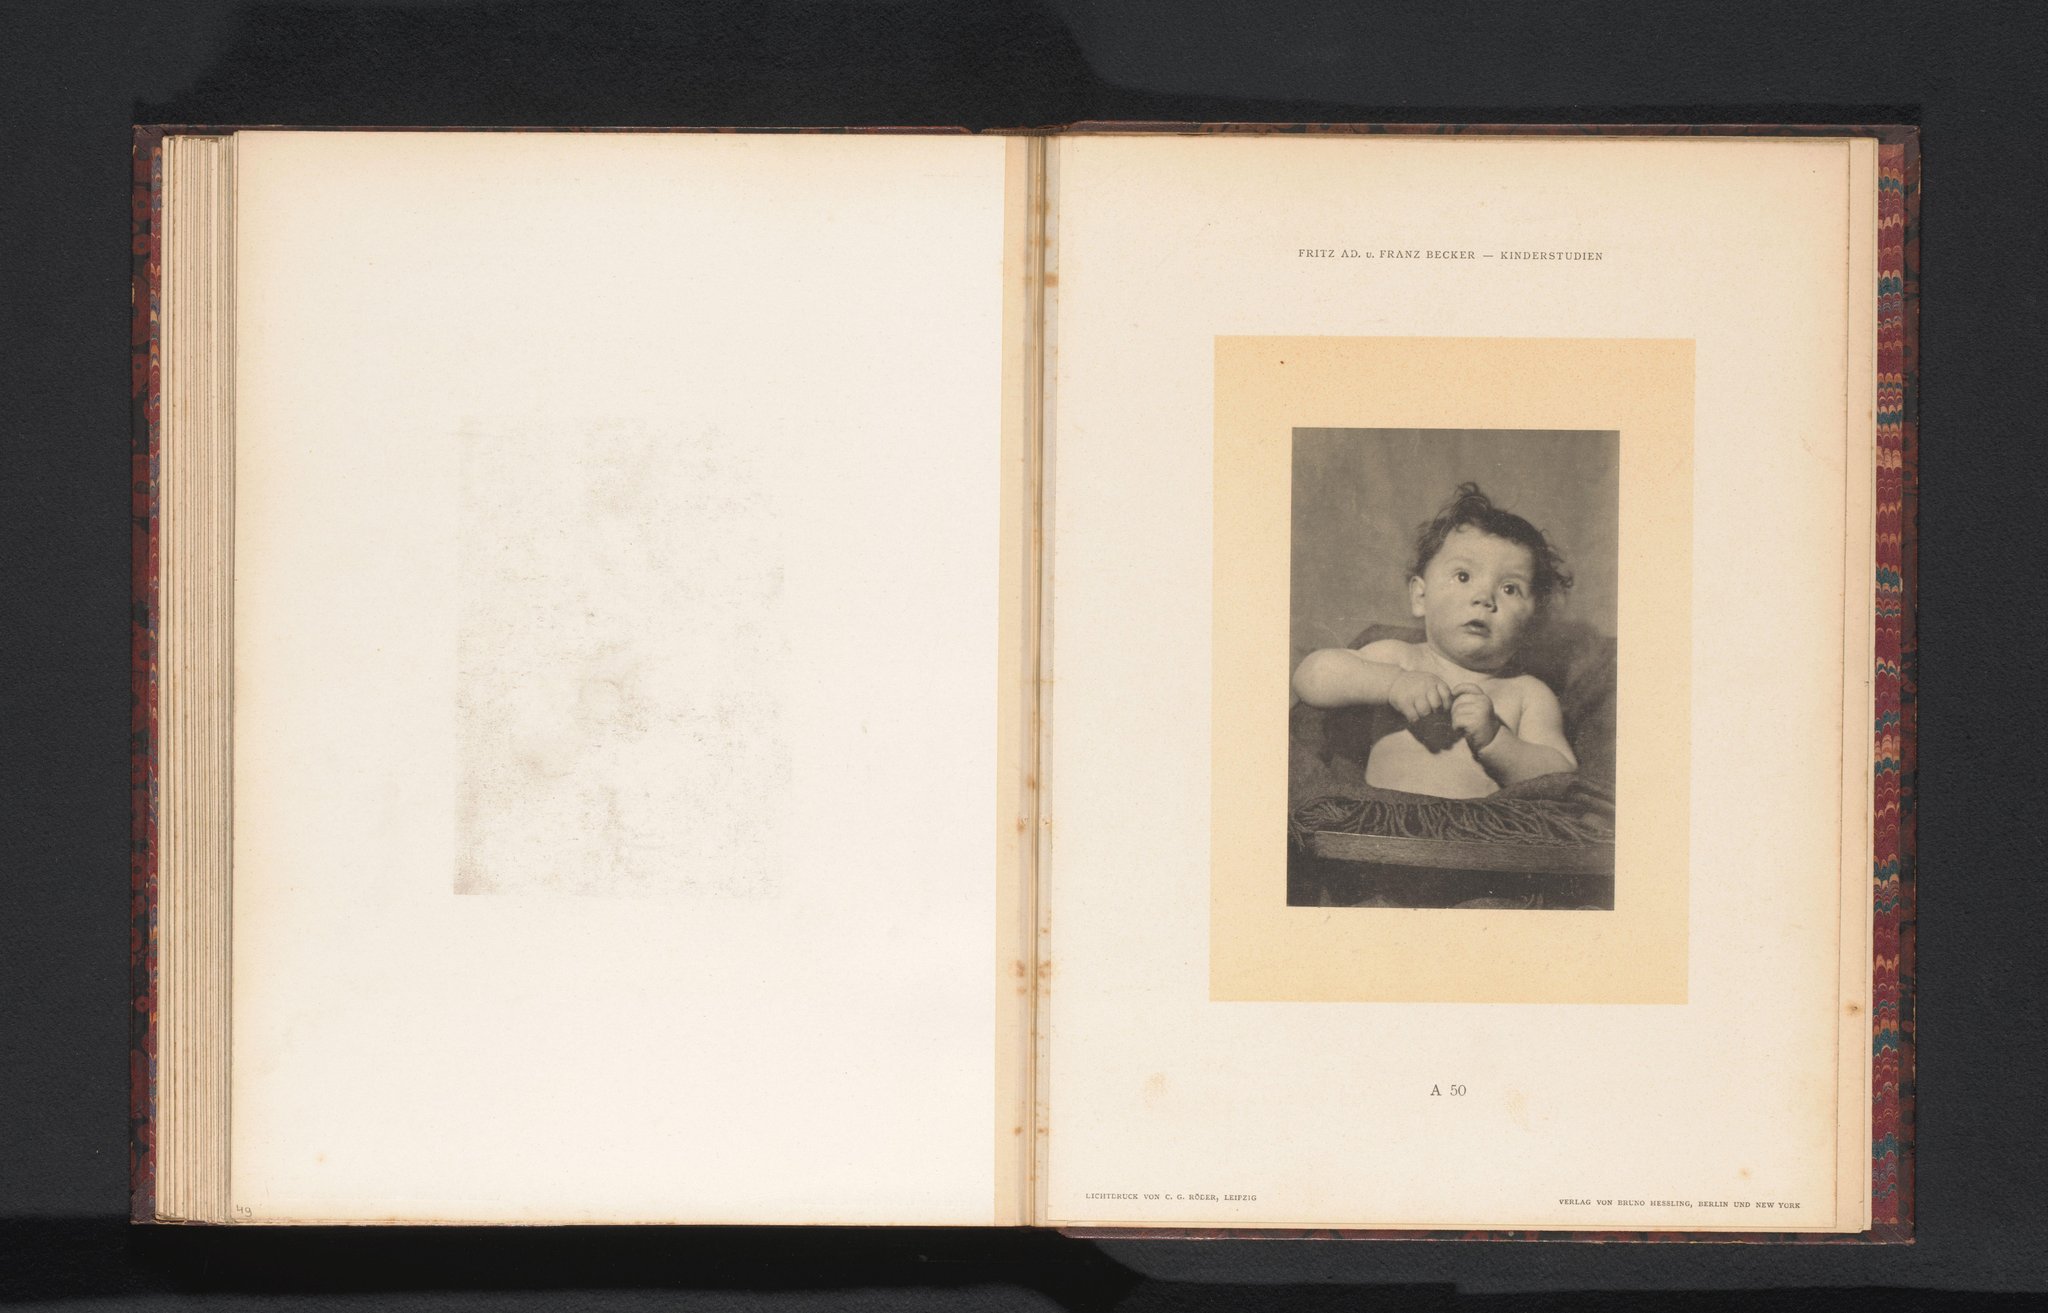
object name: photomechanical print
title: Zittend kind in een stoel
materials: paper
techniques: photograph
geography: new york city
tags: tot, toddler ~ the ages of man, chair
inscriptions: number: ‘A 50’